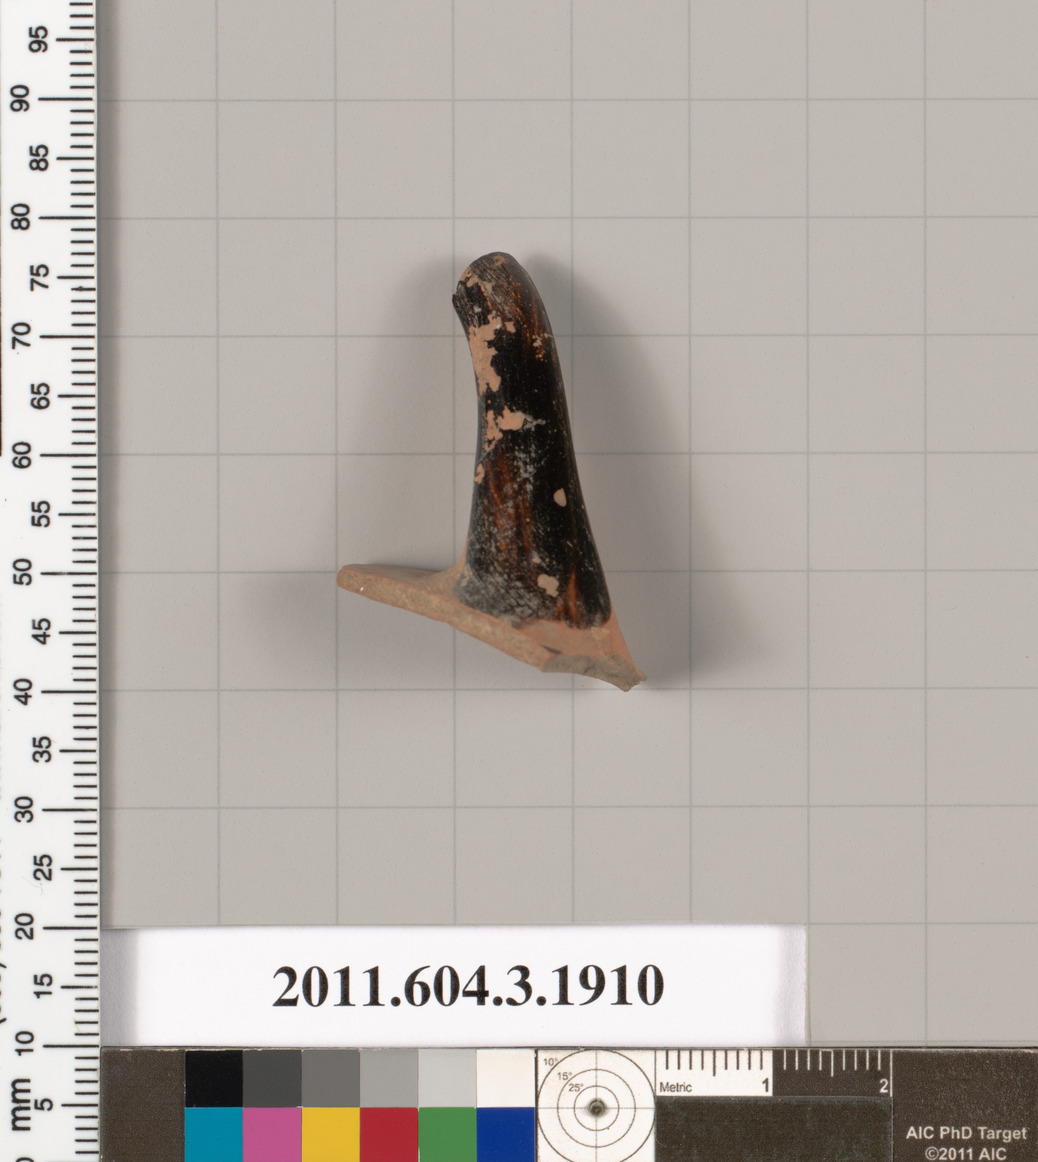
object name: kylix or skyphos fragment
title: Terracotta fragment of a kylix (drinking cup) or a skyphos (deep drinking cup)?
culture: greek, attic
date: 534-468 BCE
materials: terracotta